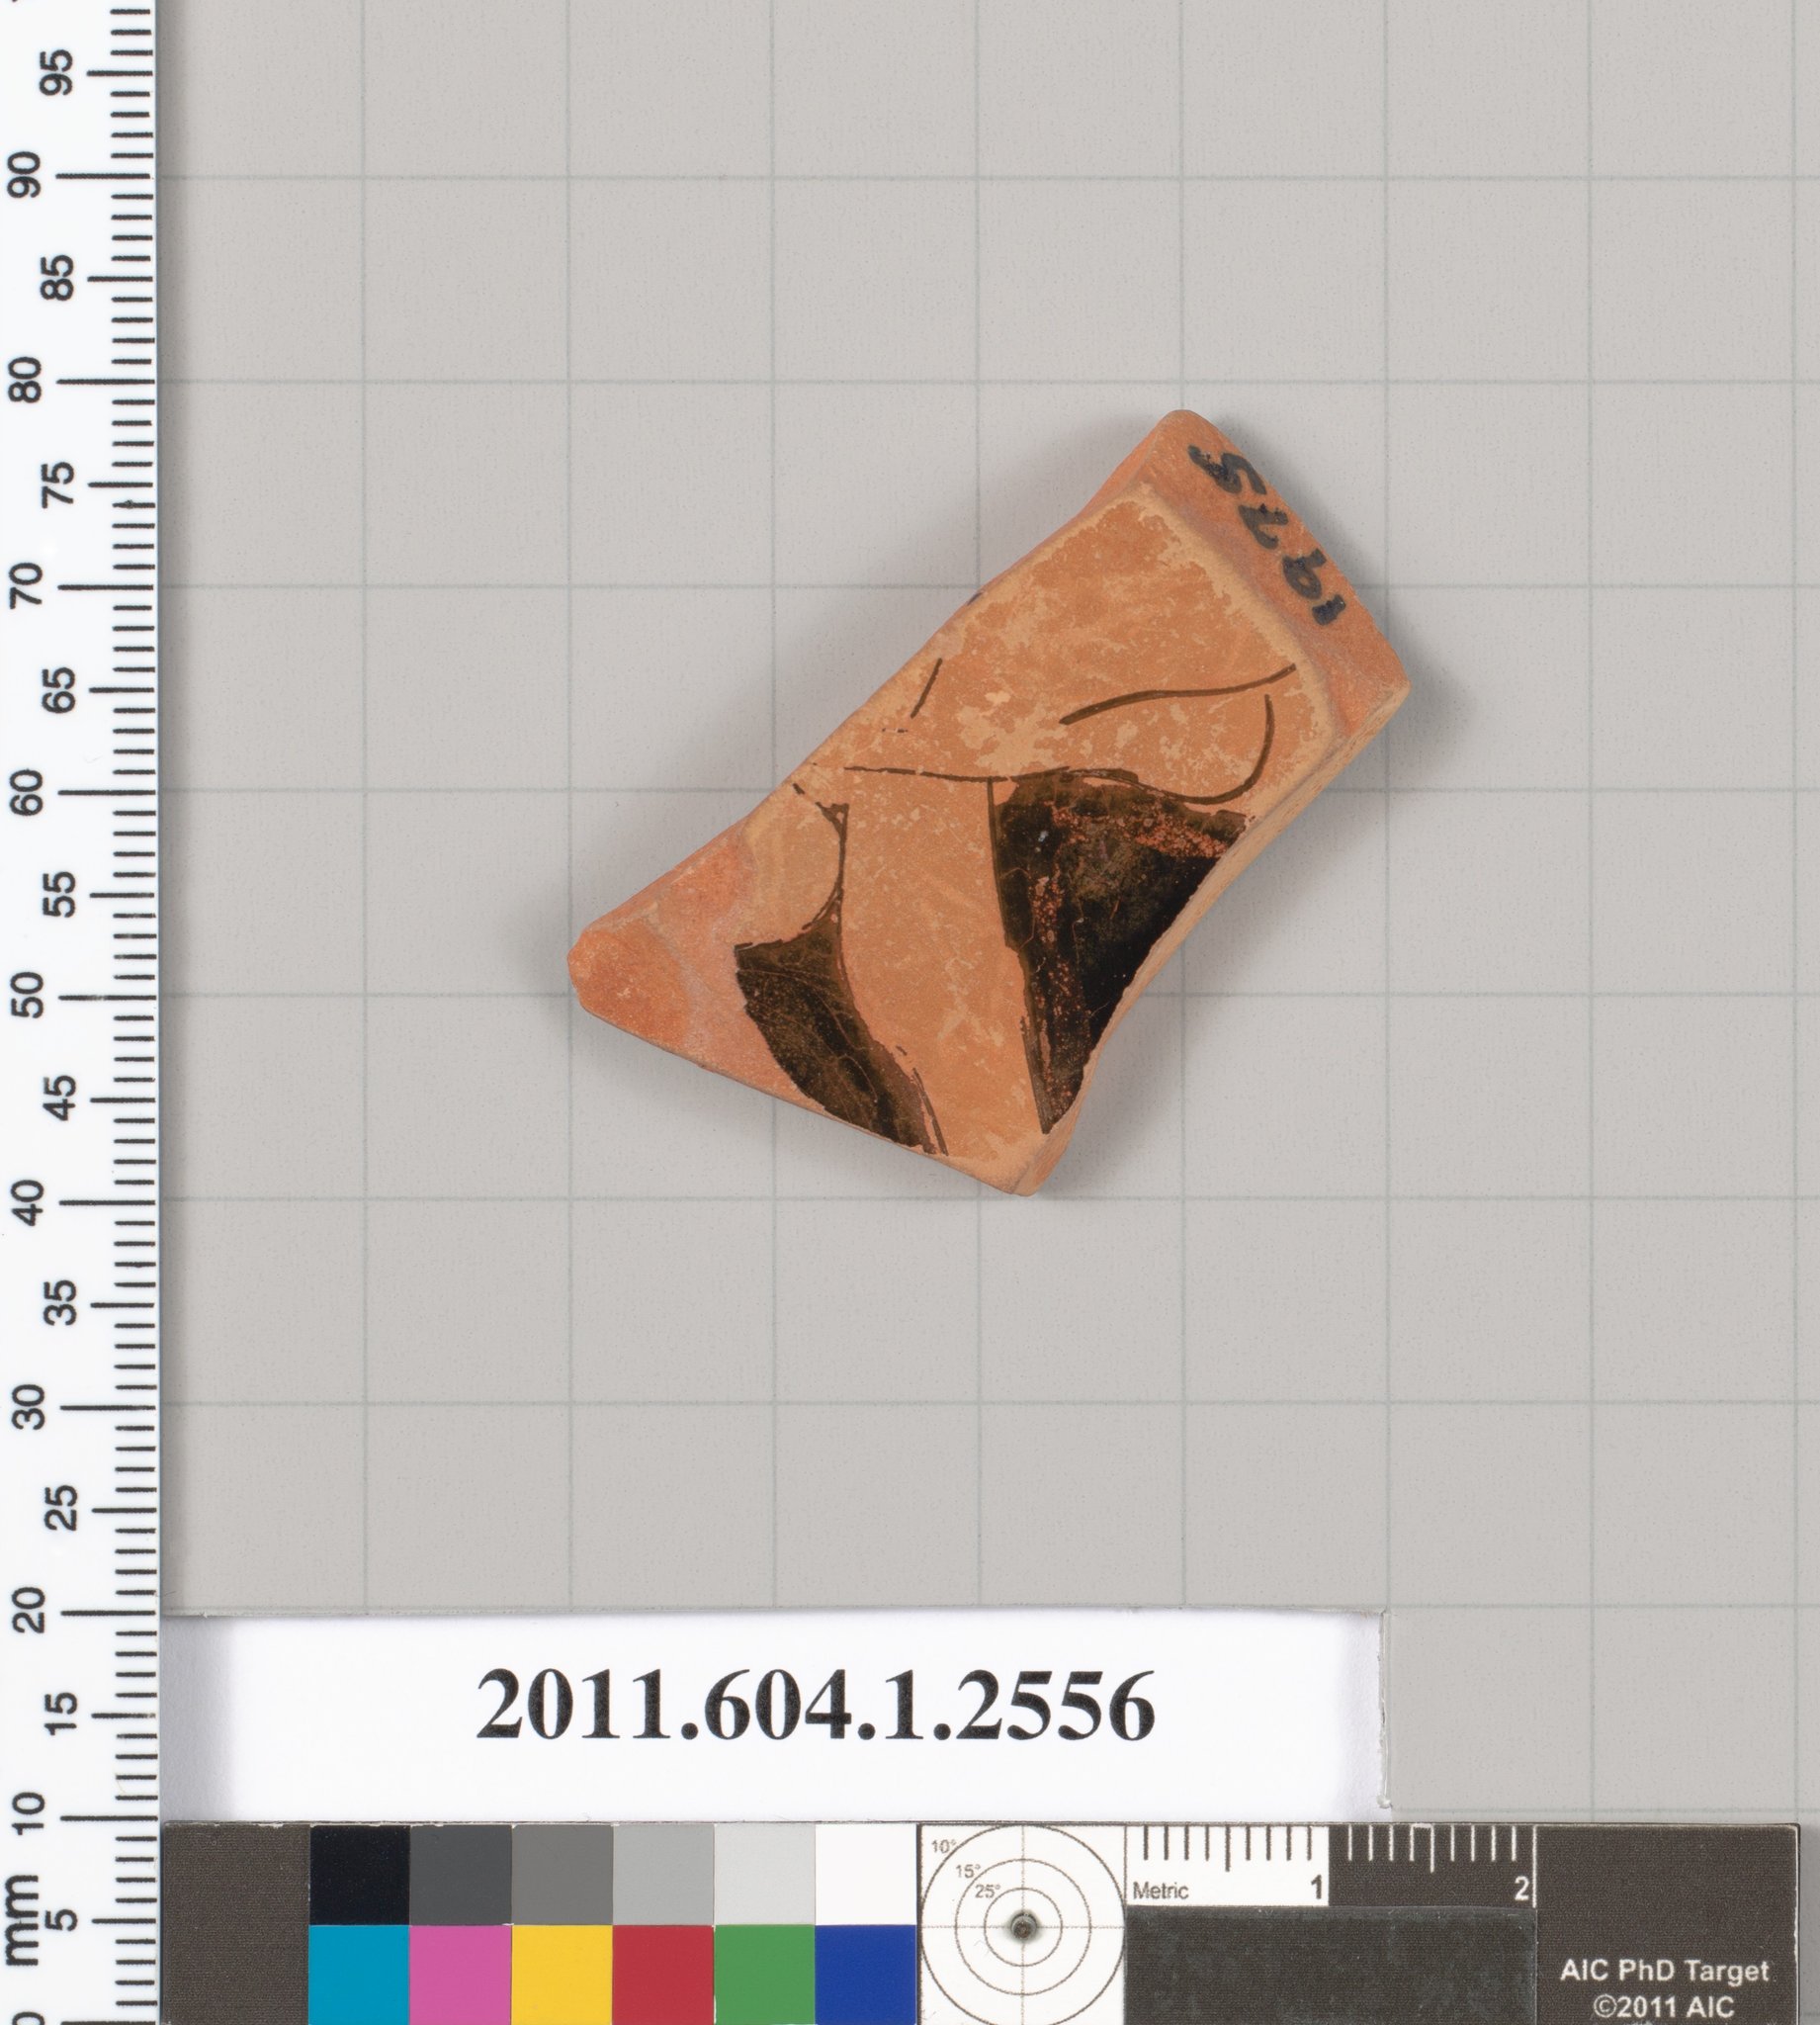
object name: kylix fragment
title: Terracotta fragment of a kylix (drinking cup)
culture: greek, attic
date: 475-451 BCE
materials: terracotta